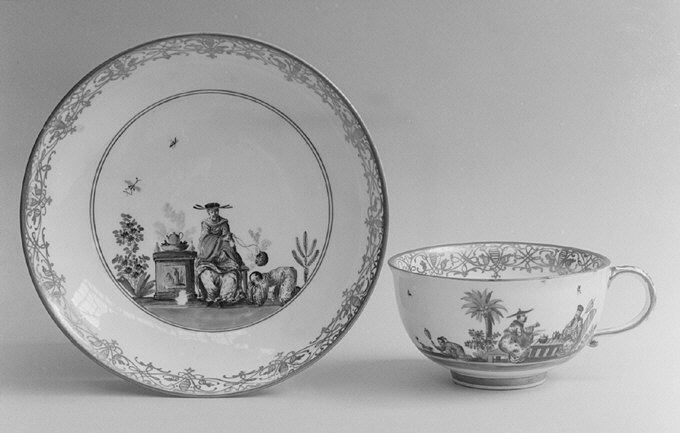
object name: cup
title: Cup (part of a set)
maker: meissen manufactory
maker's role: manufactory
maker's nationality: german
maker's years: 1710-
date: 1735-1740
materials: hard paste porcelain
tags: chinoiserie,men